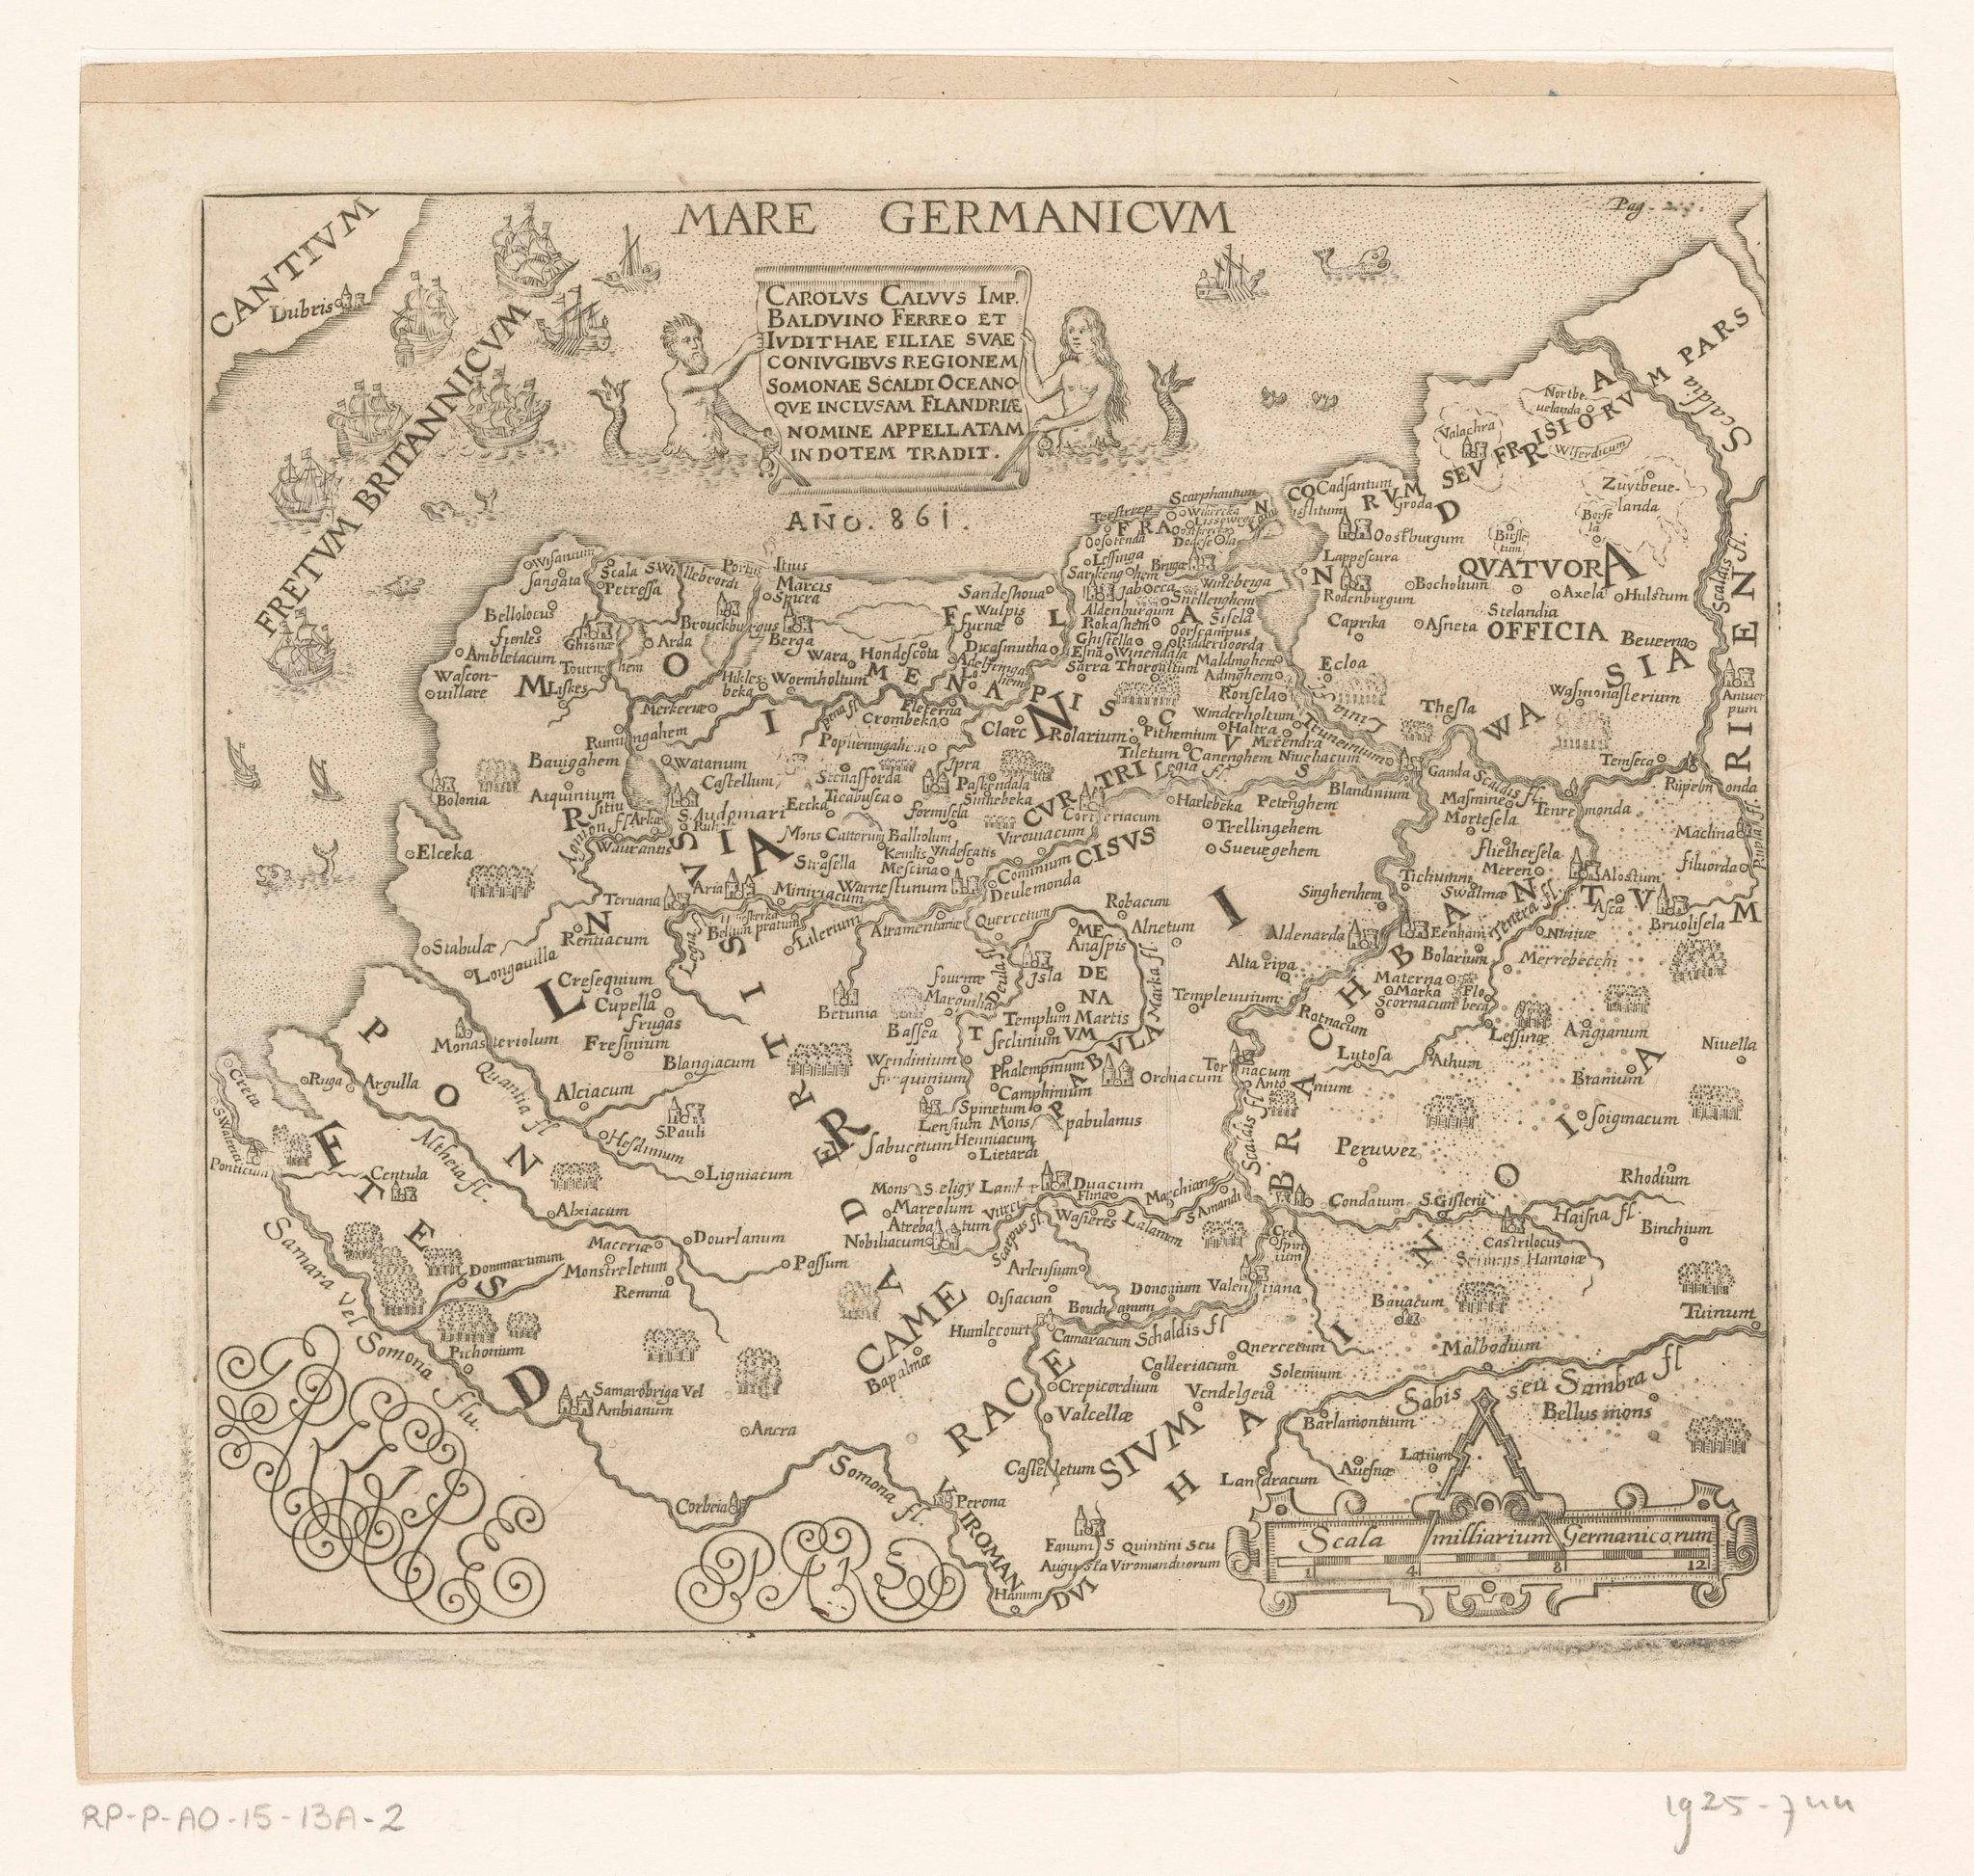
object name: print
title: Kaart van Zeeland en Vlaanderen, 861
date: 1696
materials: paper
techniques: engraving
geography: middelburg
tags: maps of separate countries or regions, zeeland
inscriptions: collector's mark: Lugt 2228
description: Kaart van Zeeland en Vlaanderen zoals het gebied eruit zou hebben gezien in 861. Rechtsonder een schaalstok: Scala milliarium Germanicorum. Rechtsboven gemerkt: Pag. 209. Oriëntatie: noorden rechts.